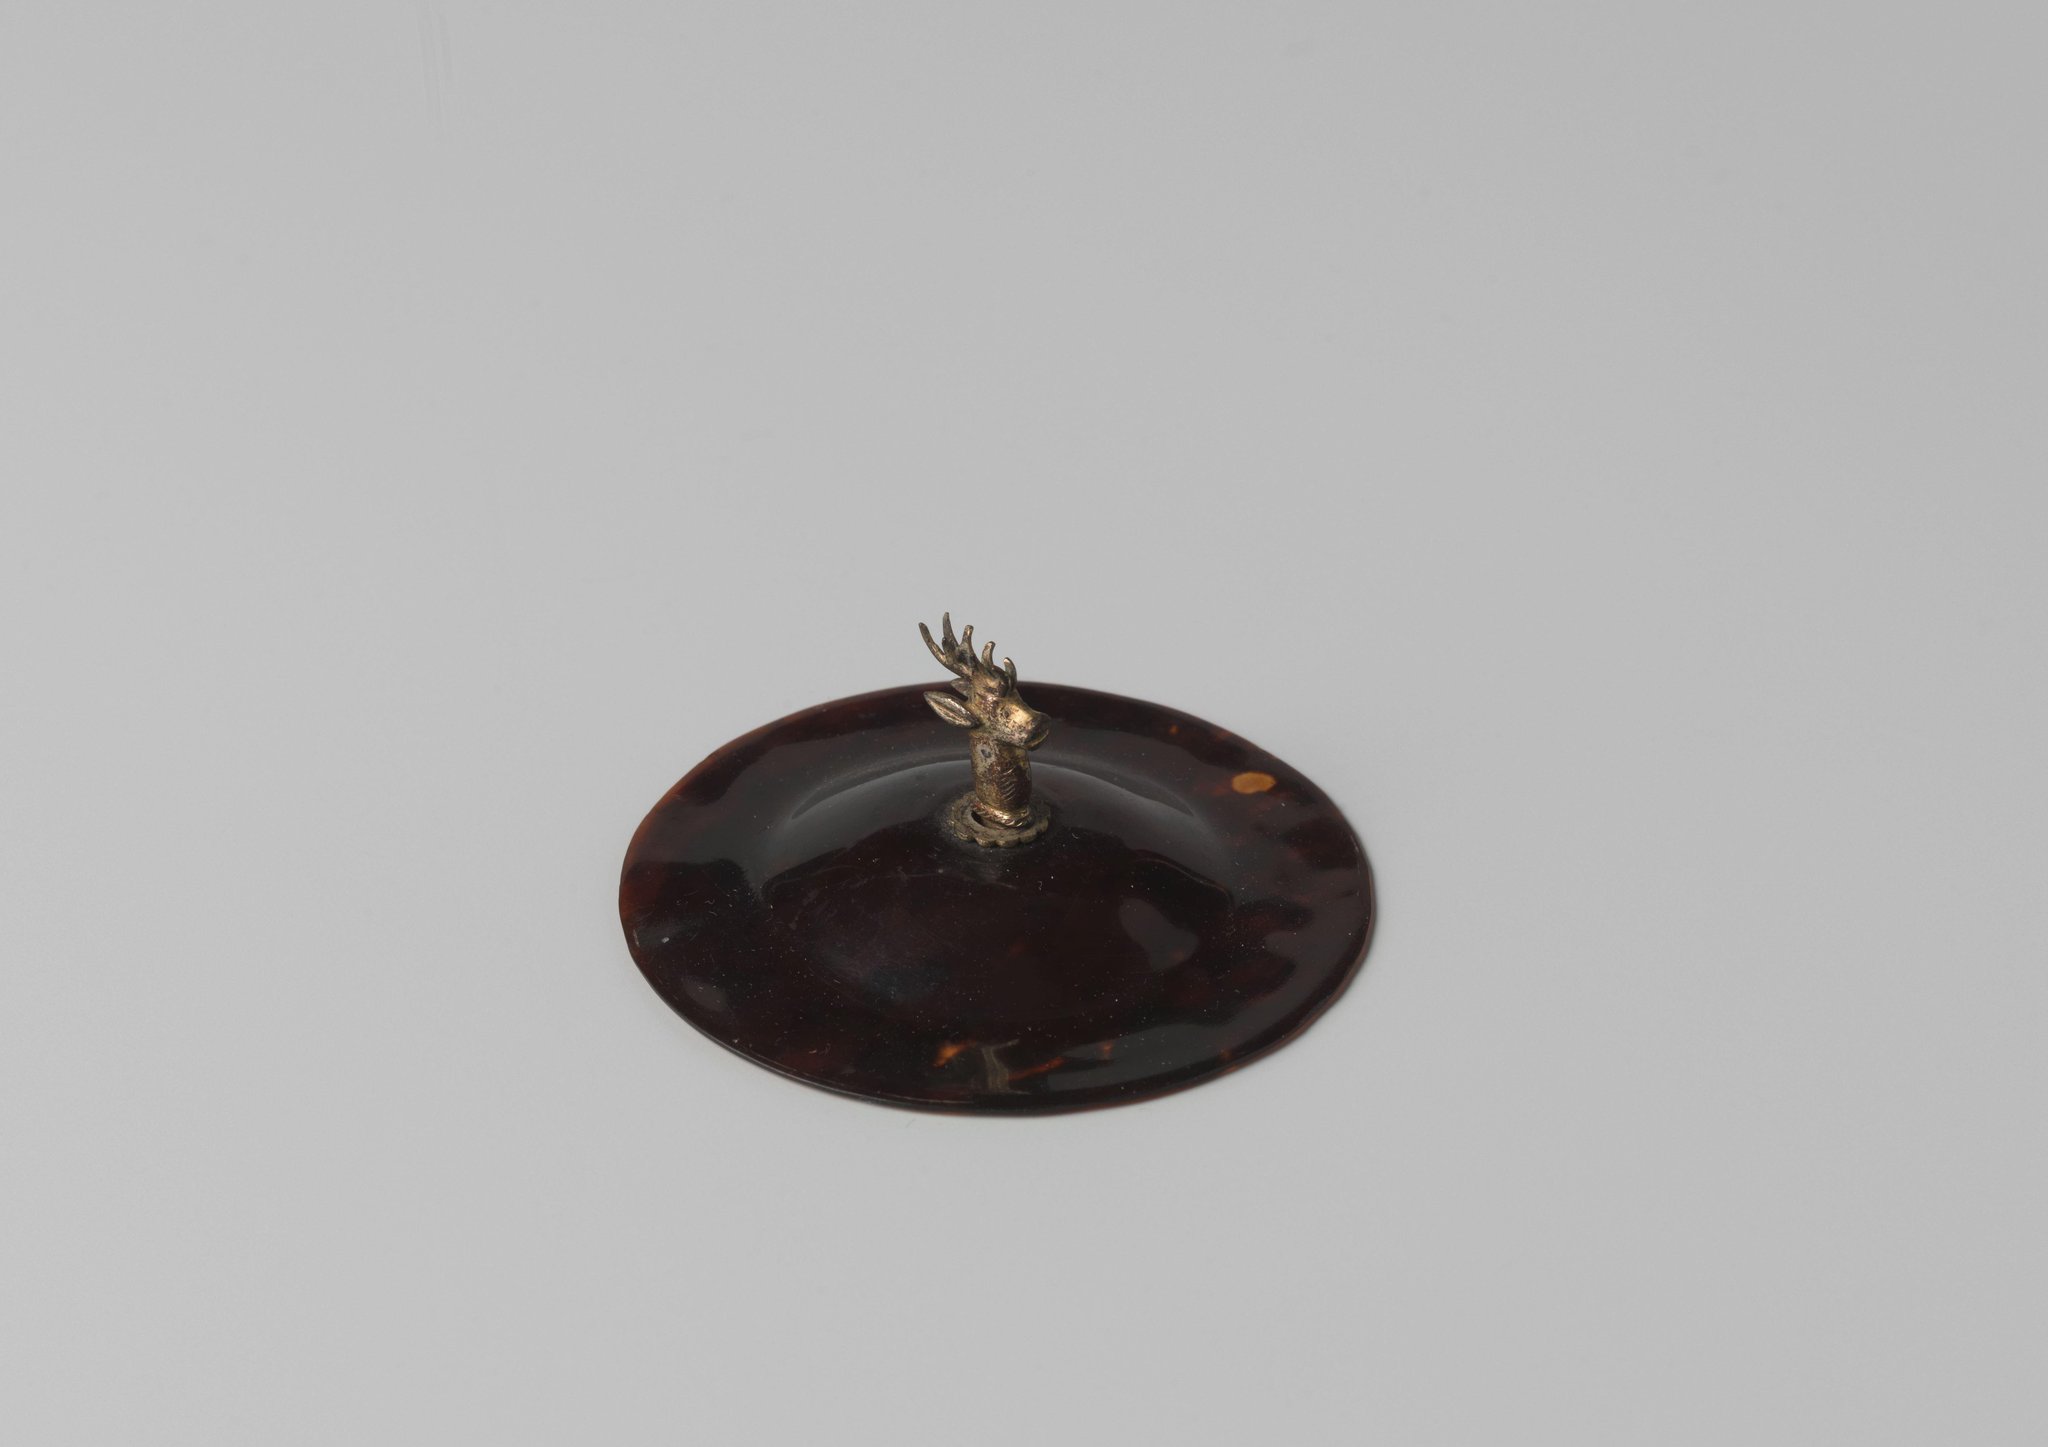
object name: service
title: Deksel van schildpad met hertekop van zilver (serie van 28 stuks A t/m BB)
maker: Anonymous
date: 1700-1799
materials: silver, shell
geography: indonesia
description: Deksel van schildpad met hertekop van zilver (serie van 28 stuks A t/m BB), Indonesië, 18de eeuw?